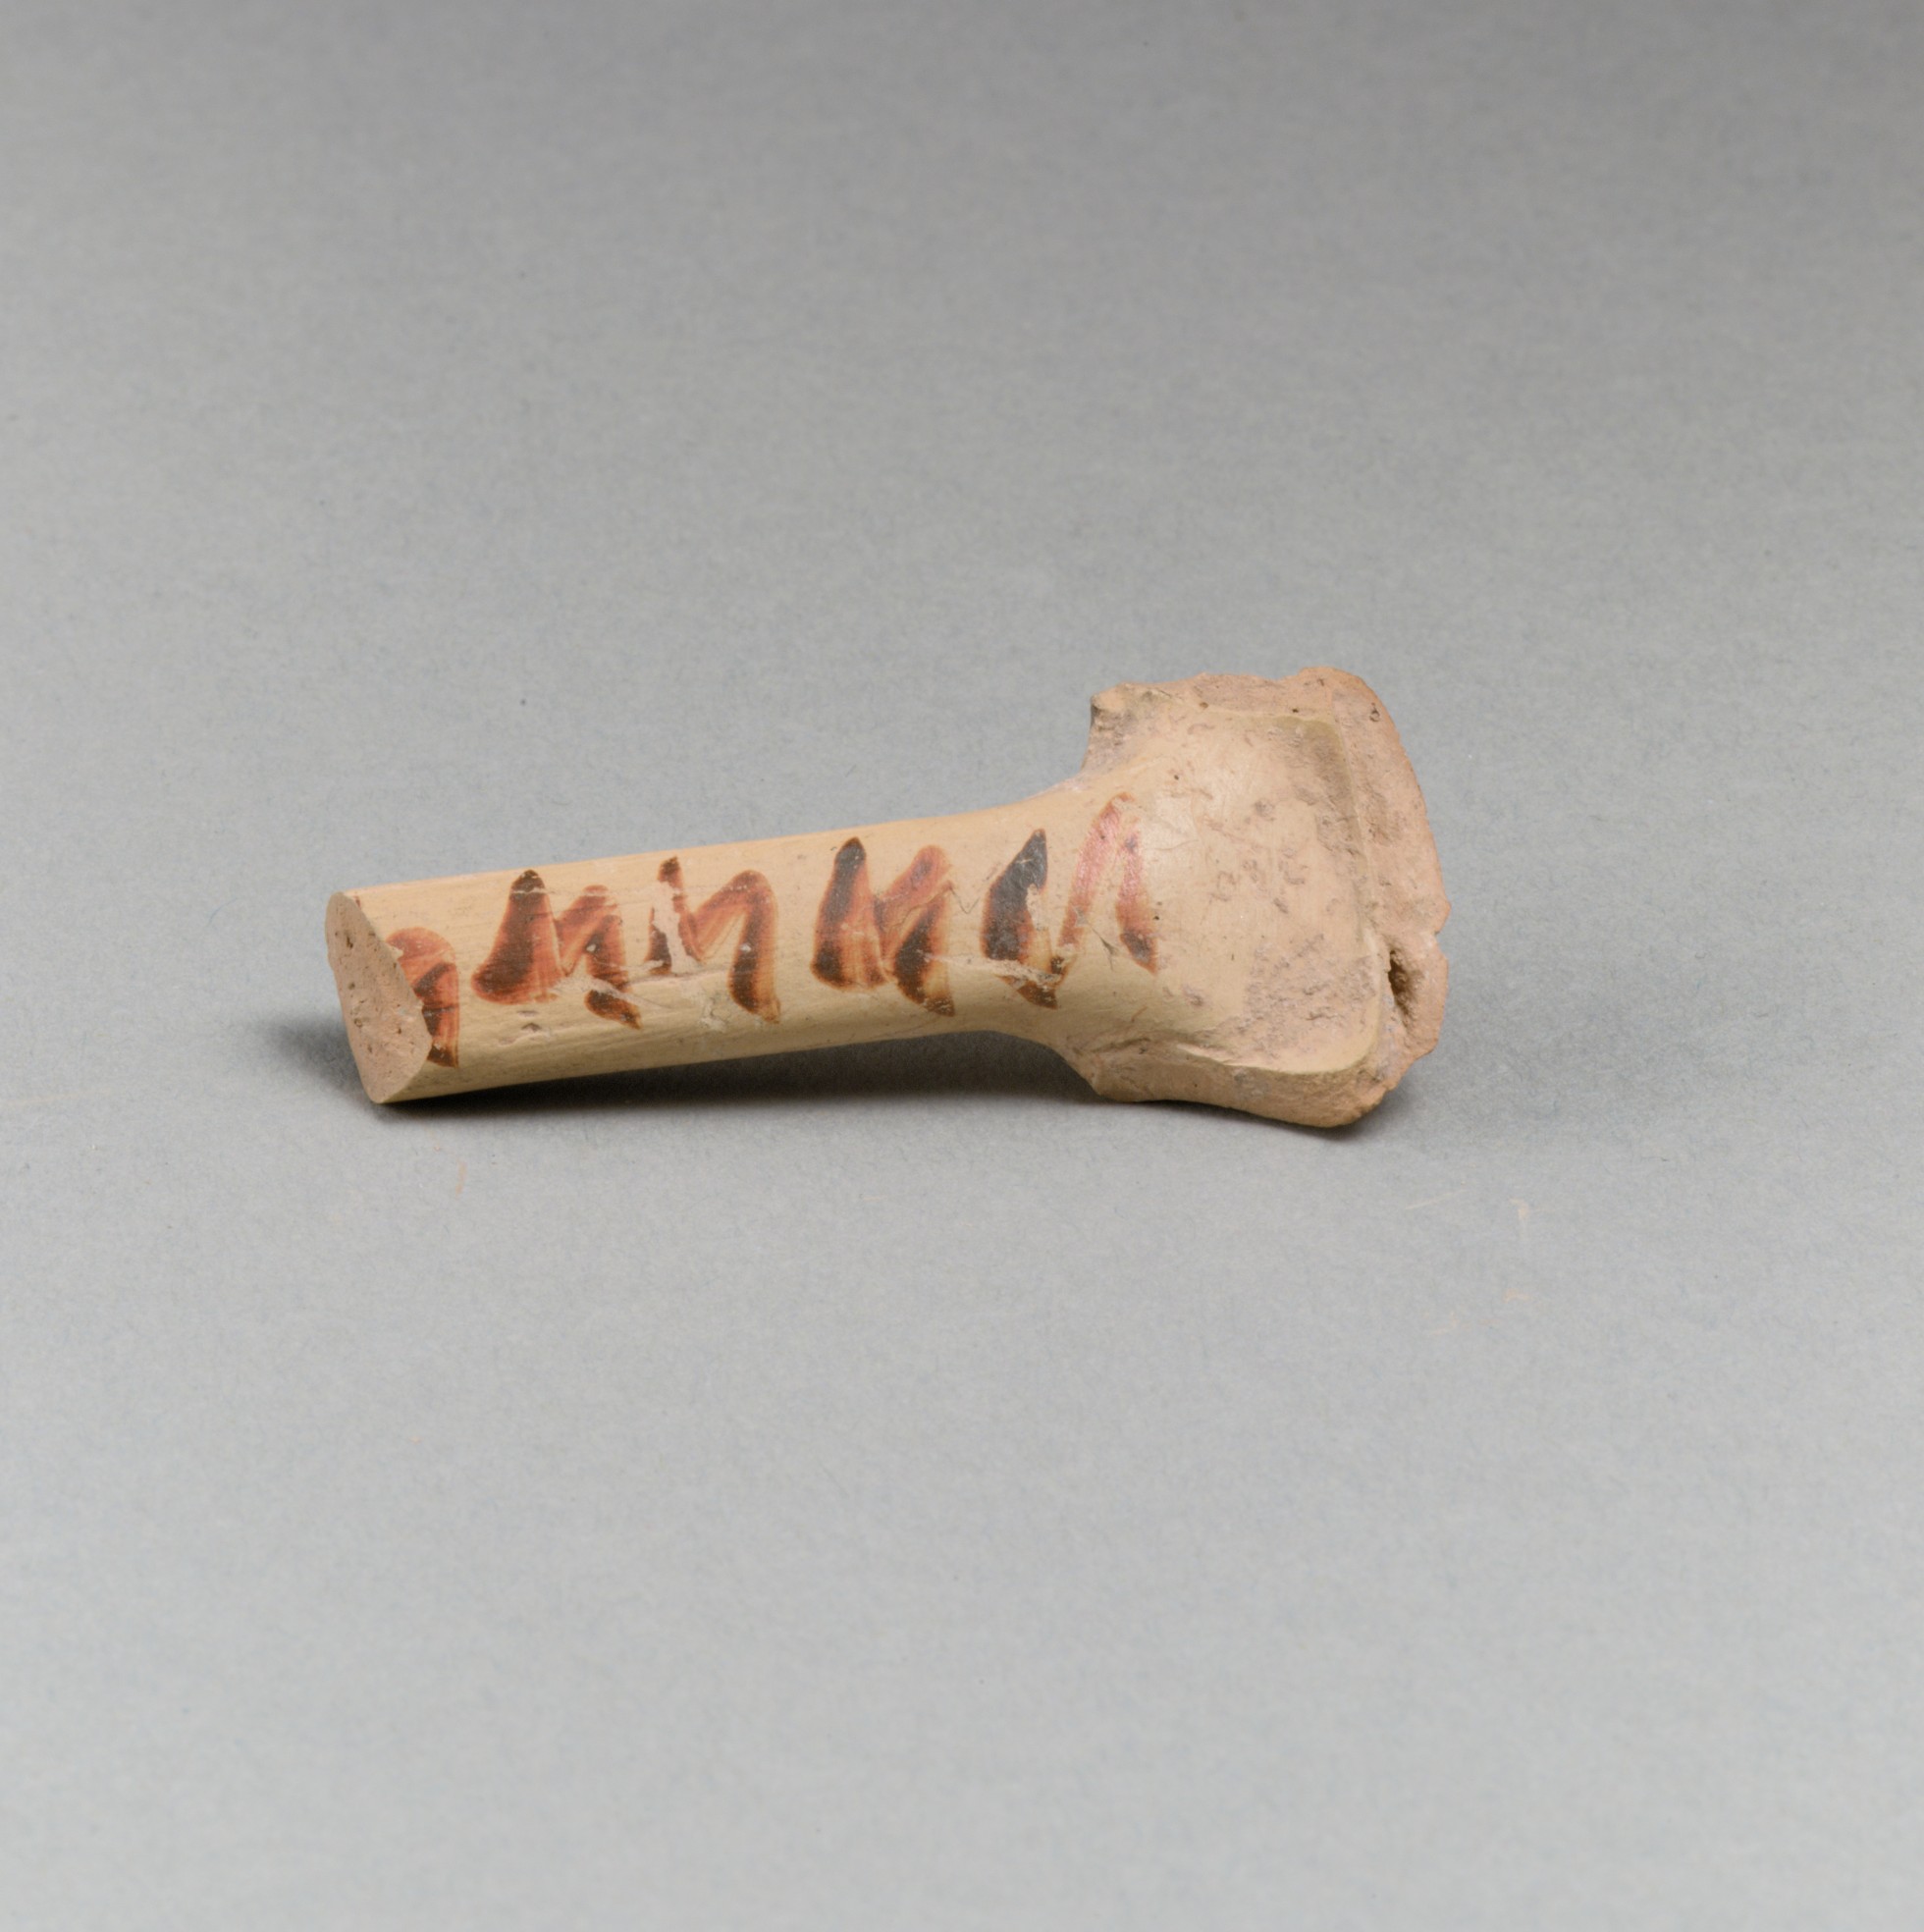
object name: vase fragment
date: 3000-2200 BCE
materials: terracotta